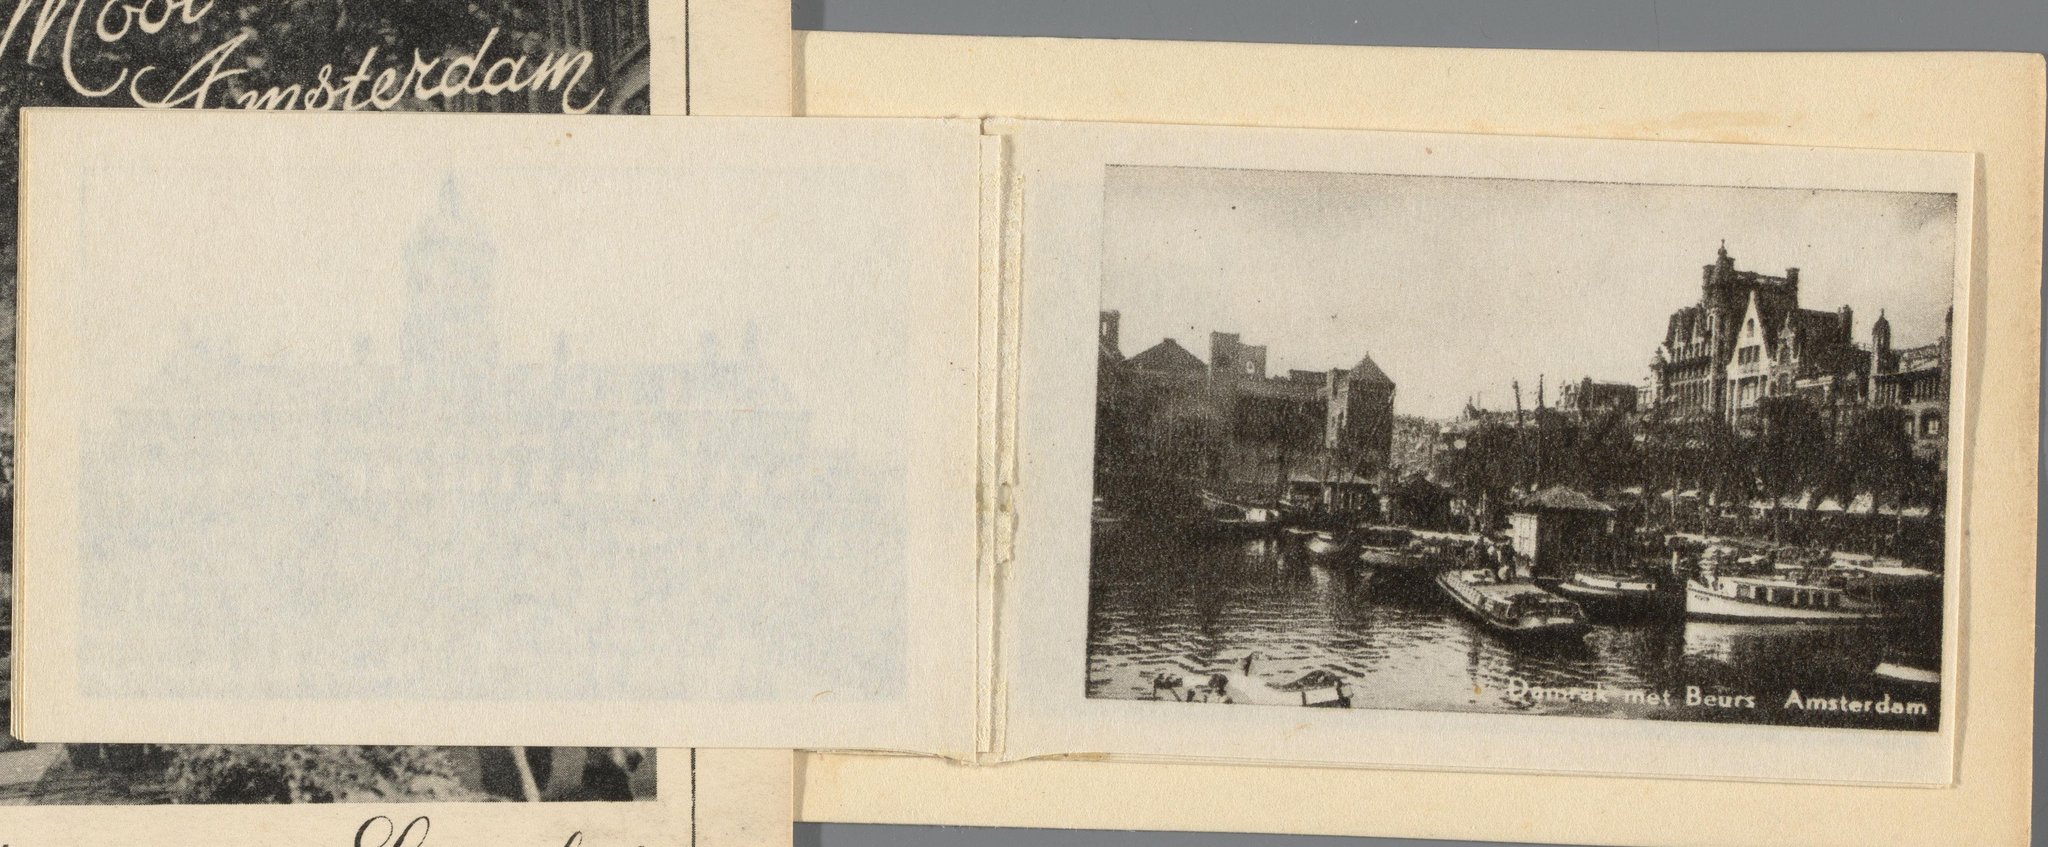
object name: photomechanical print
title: Gezicht op het Damrak met de Beurs in Amsterdam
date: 1920-1950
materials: paper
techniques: rotogravure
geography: eemnes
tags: stock exchange, stock-market, canals, waters (in city)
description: Deze prent maakt deel uit van een omslag met tien prenten.